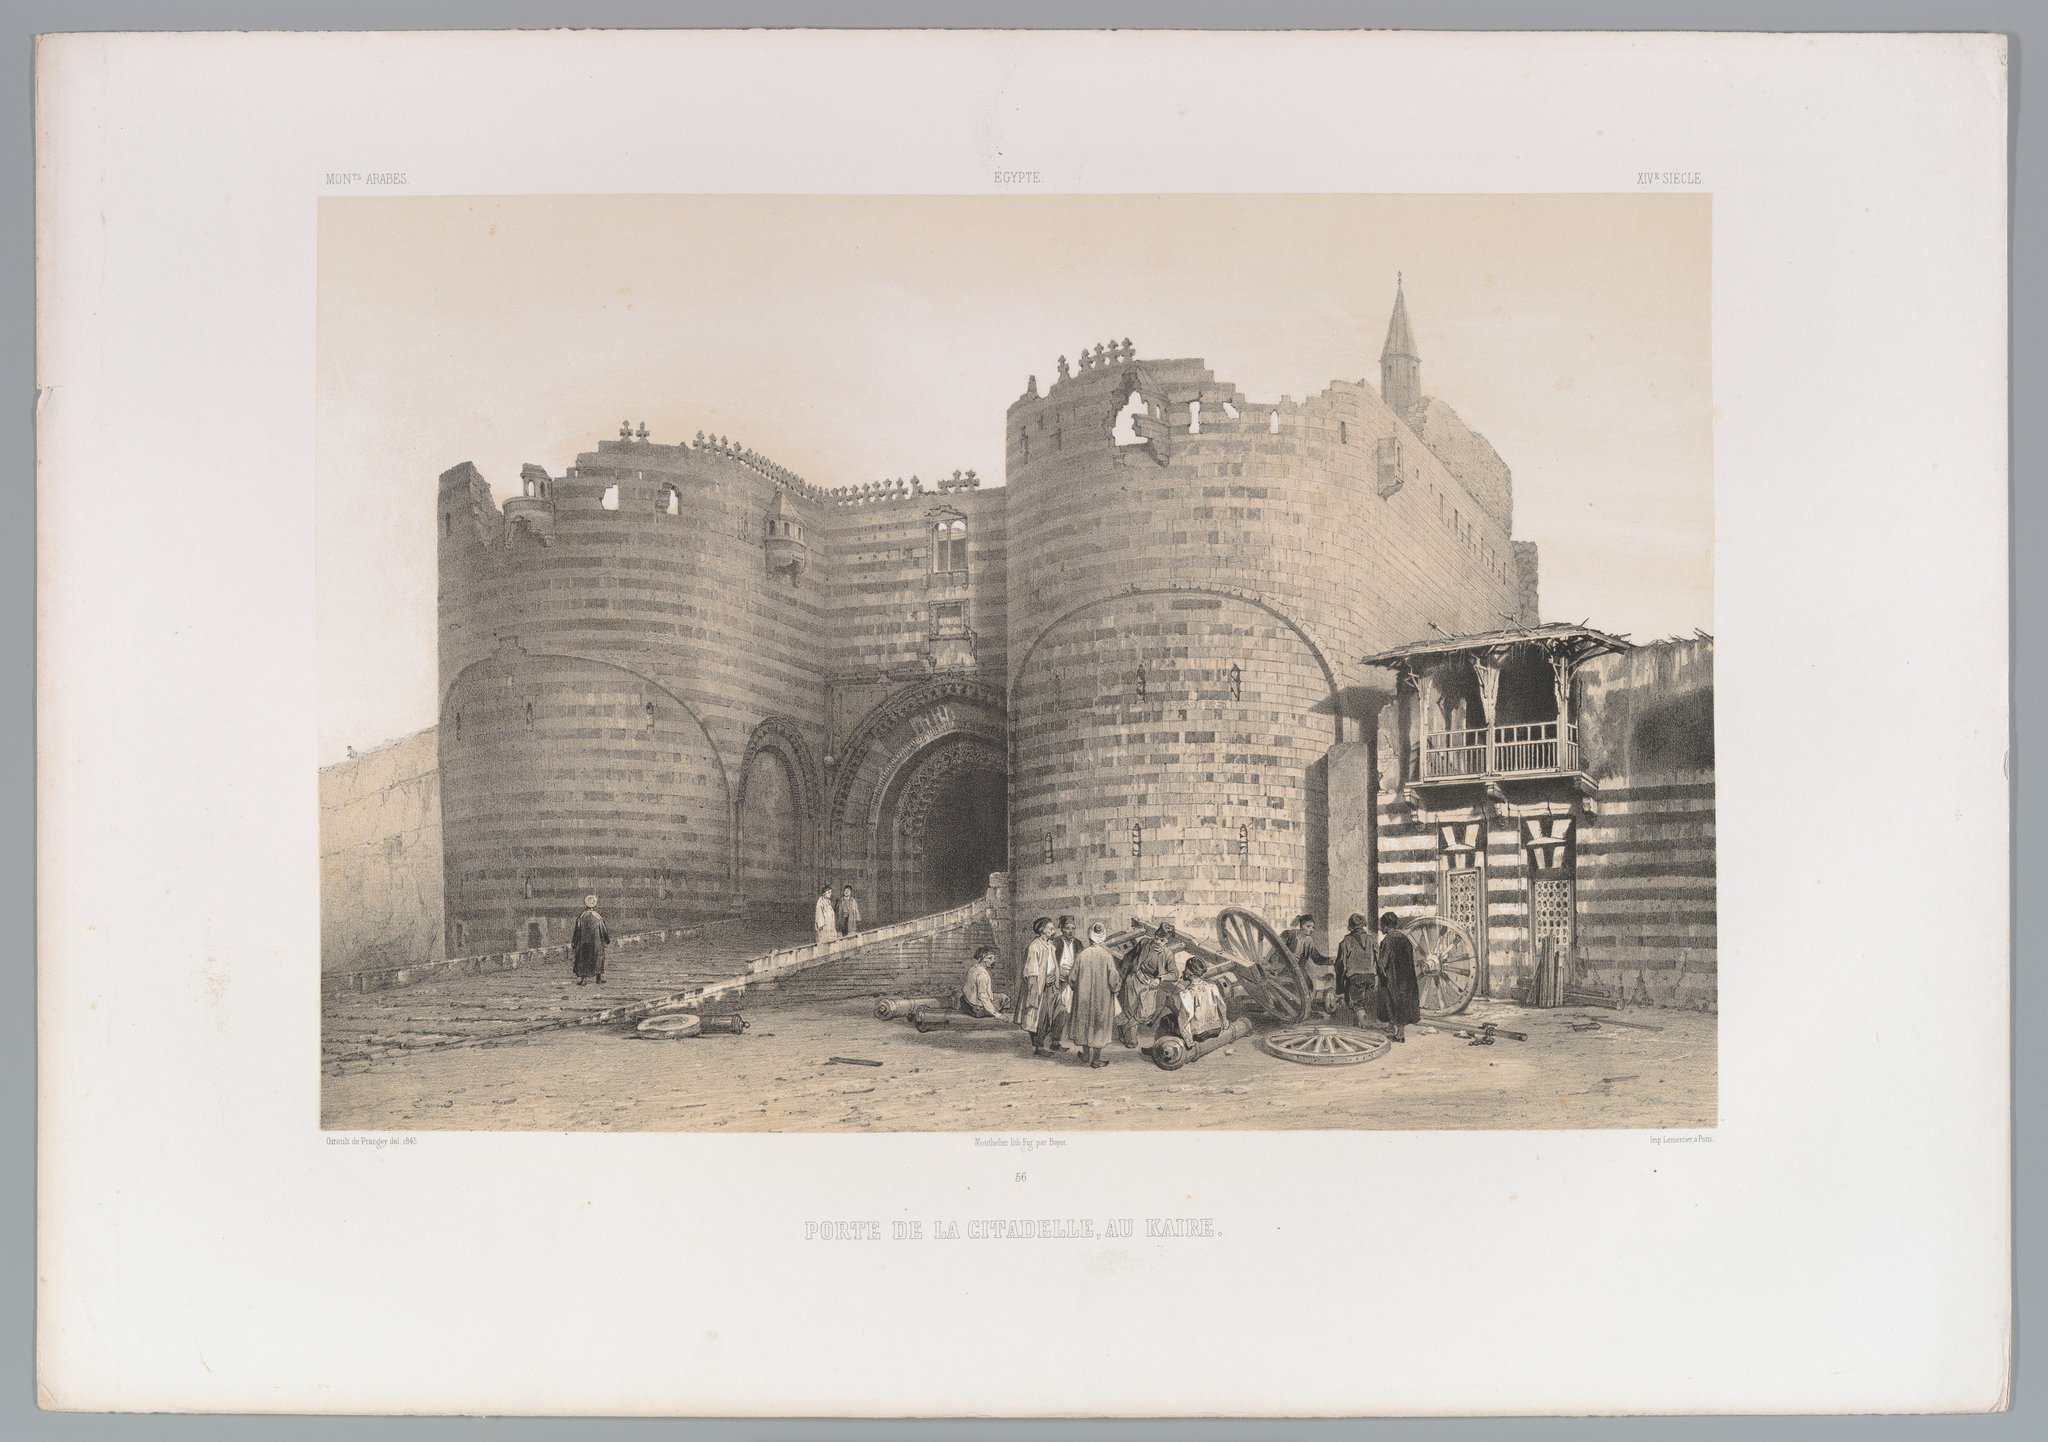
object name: lithograph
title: 56. Porte de la Citadelle, au Kaire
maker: joseph-philibert girault de prangey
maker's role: artist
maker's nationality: french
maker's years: 1804-1892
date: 1843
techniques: lithograph